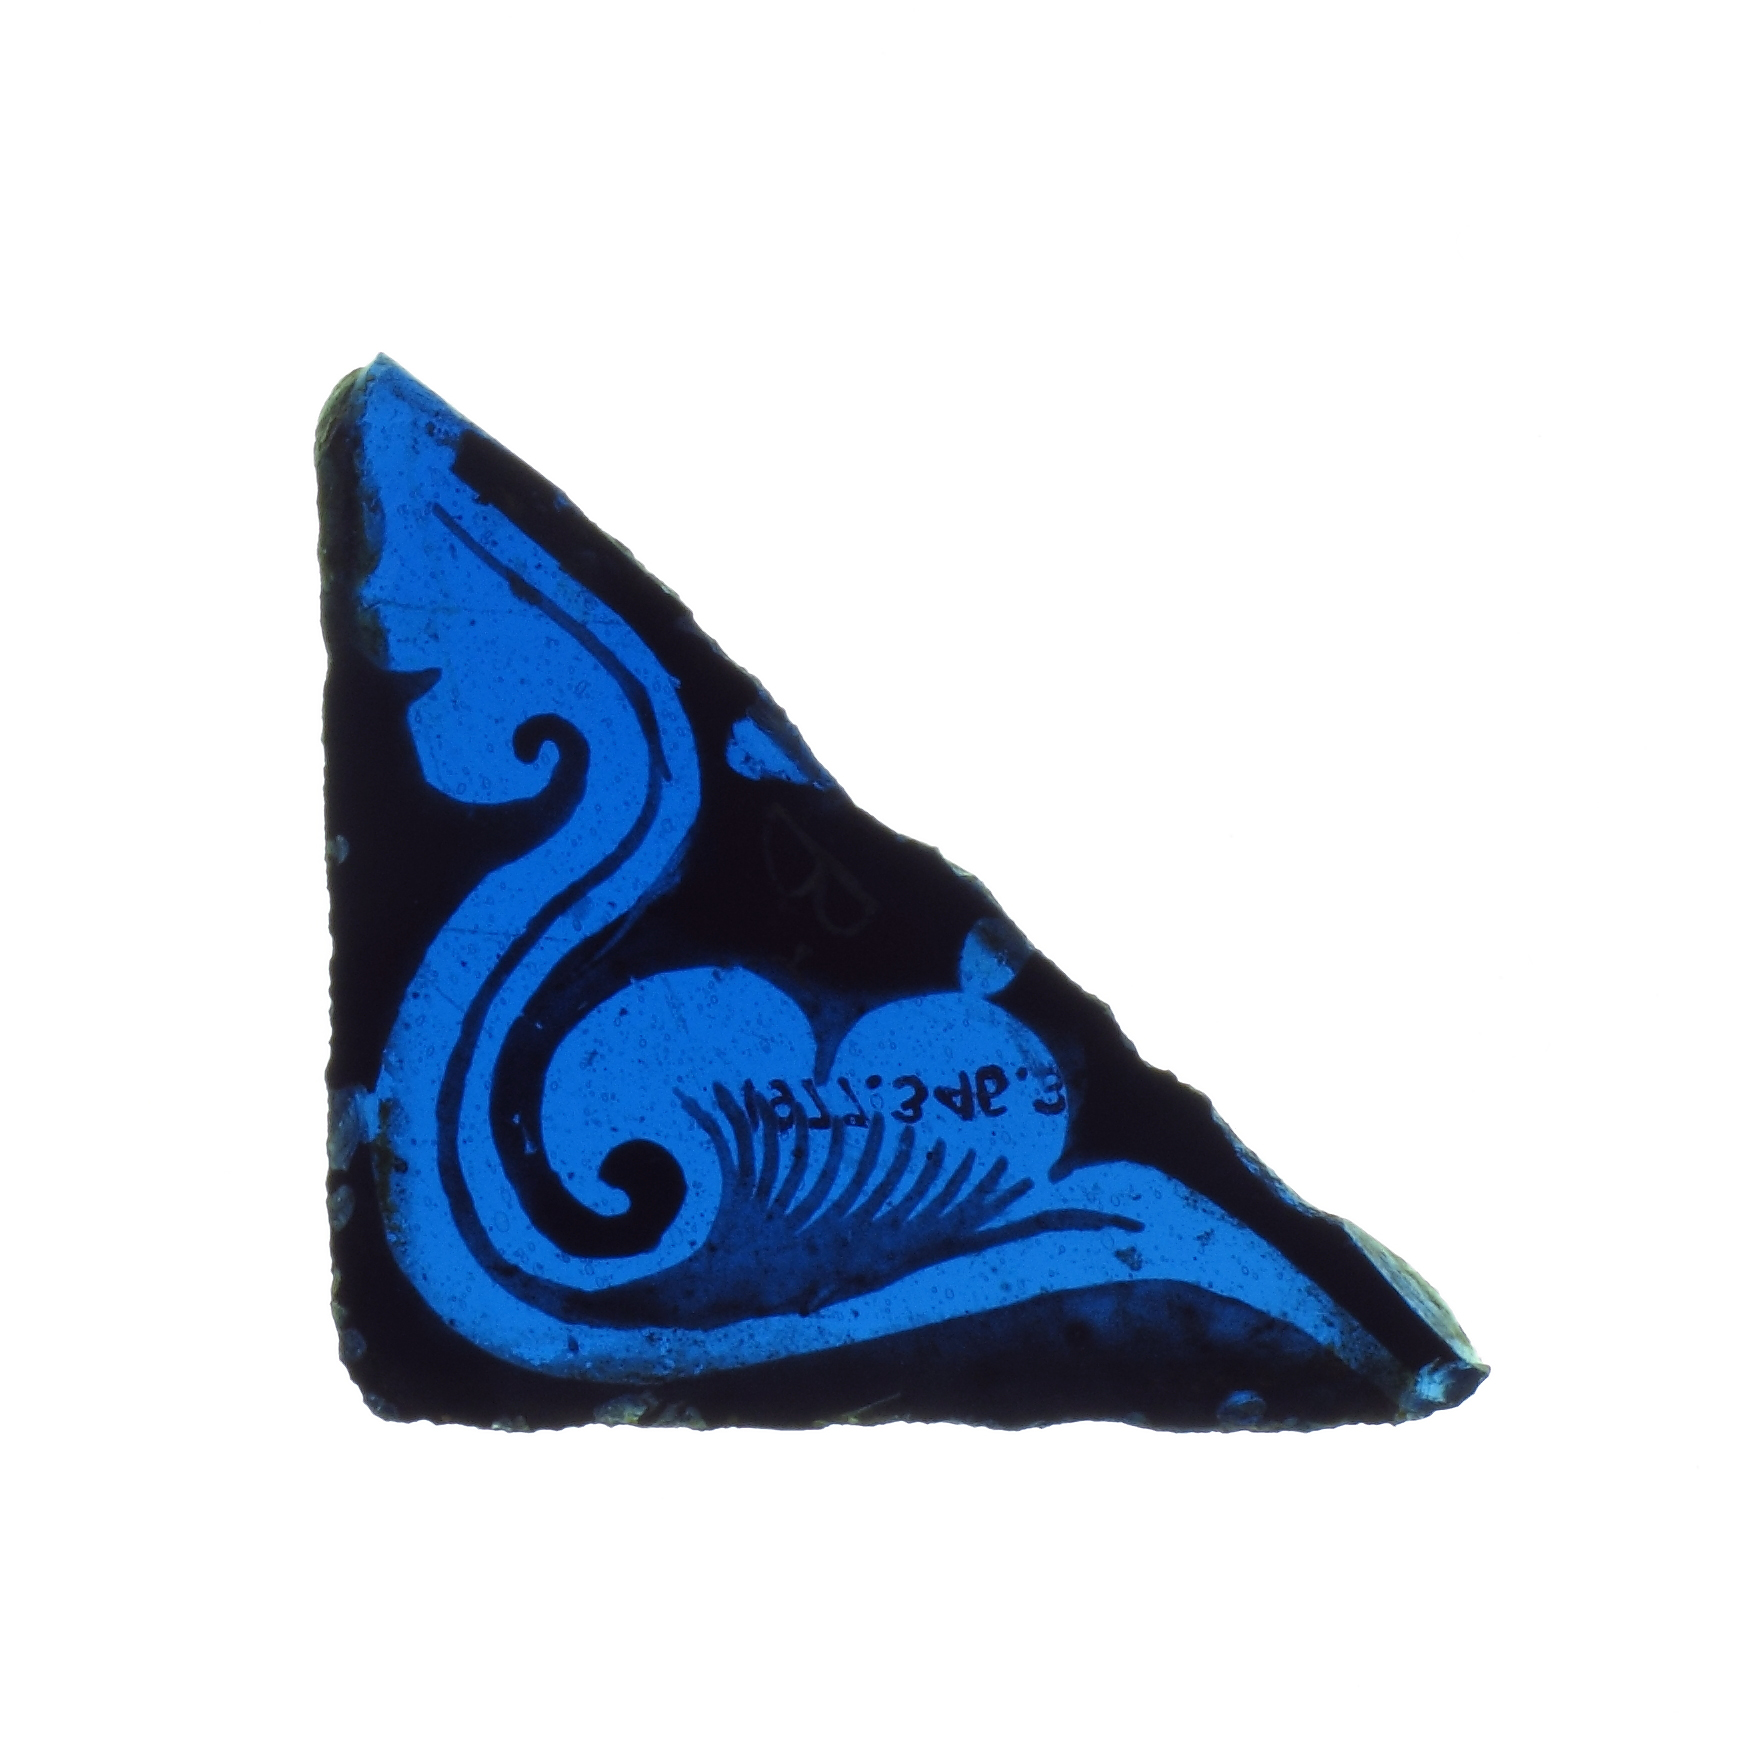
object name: fragment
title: Glass Fragment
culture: french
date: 1101-1400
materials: glass, metal, paint